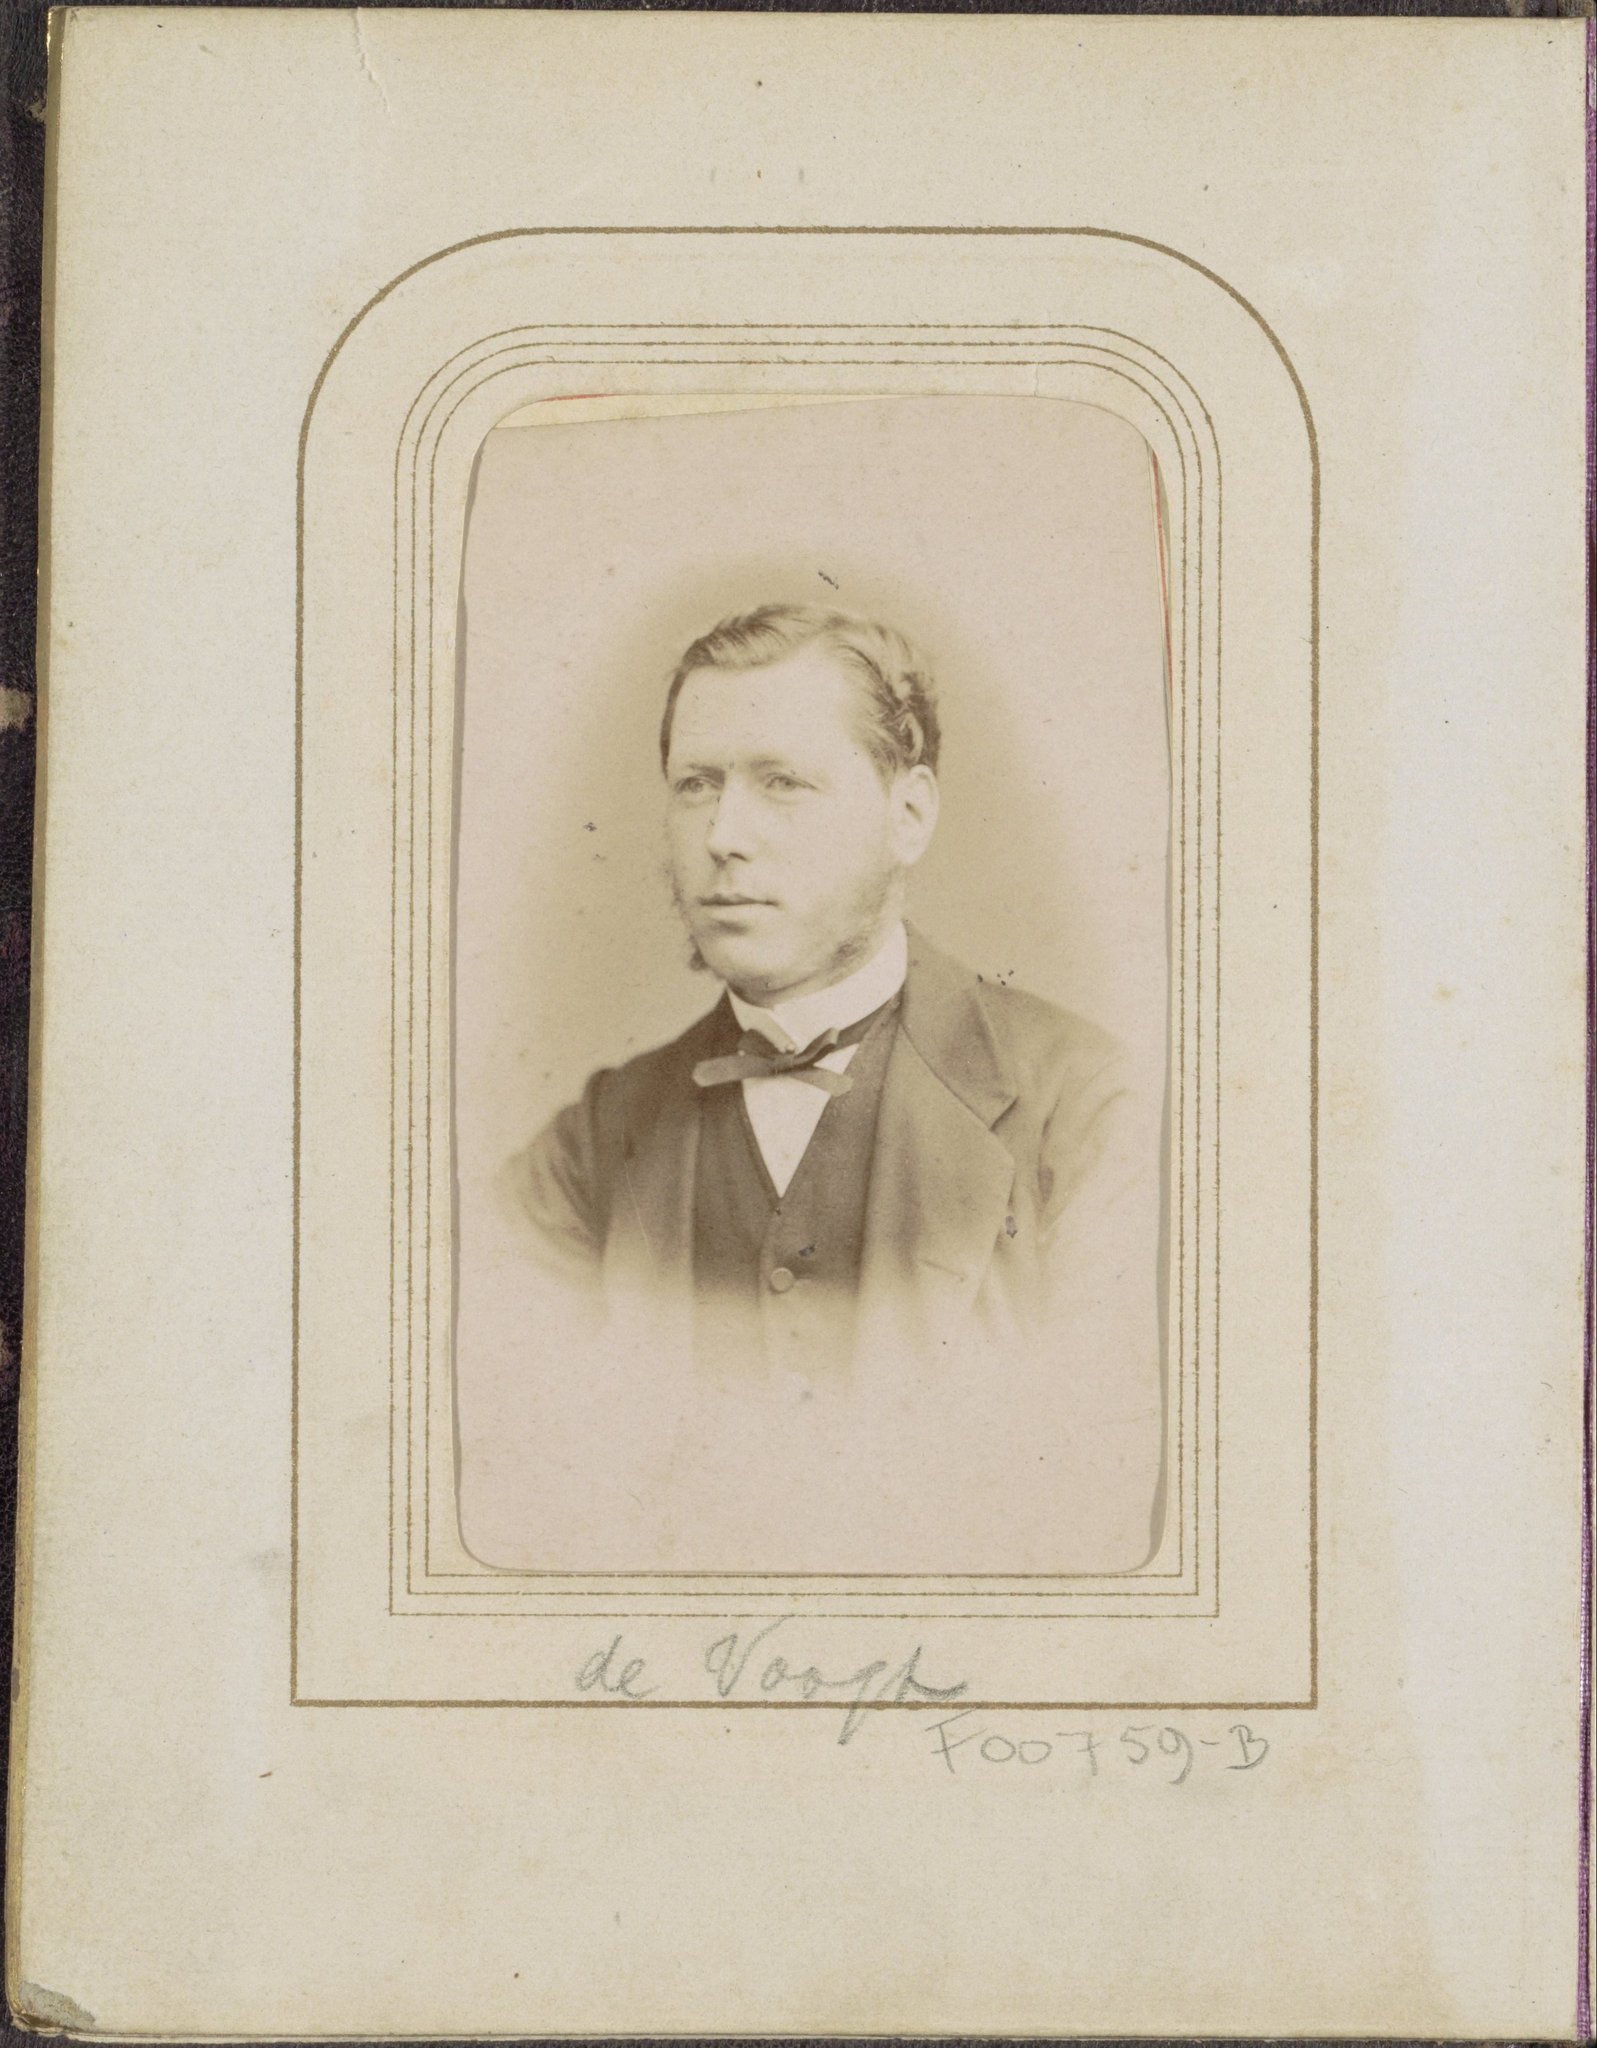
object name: carte de visite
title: Portret van een man aangeduid als De Voogt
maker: albert greiner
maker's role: fotograaf, fotostudio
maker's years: 1833-1890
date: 1862-1885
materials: cardboard, paper, photographic support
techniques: albumen print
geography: amsterdam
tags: historical persons, amsterdam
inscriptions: inscription: ‘de Voogt’, address: ‘Amsterdam, Nieuwendijk L 89’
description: Onderdeel van Fotoalbum van een Nederlandse familie met 50 cartes-de-visite.